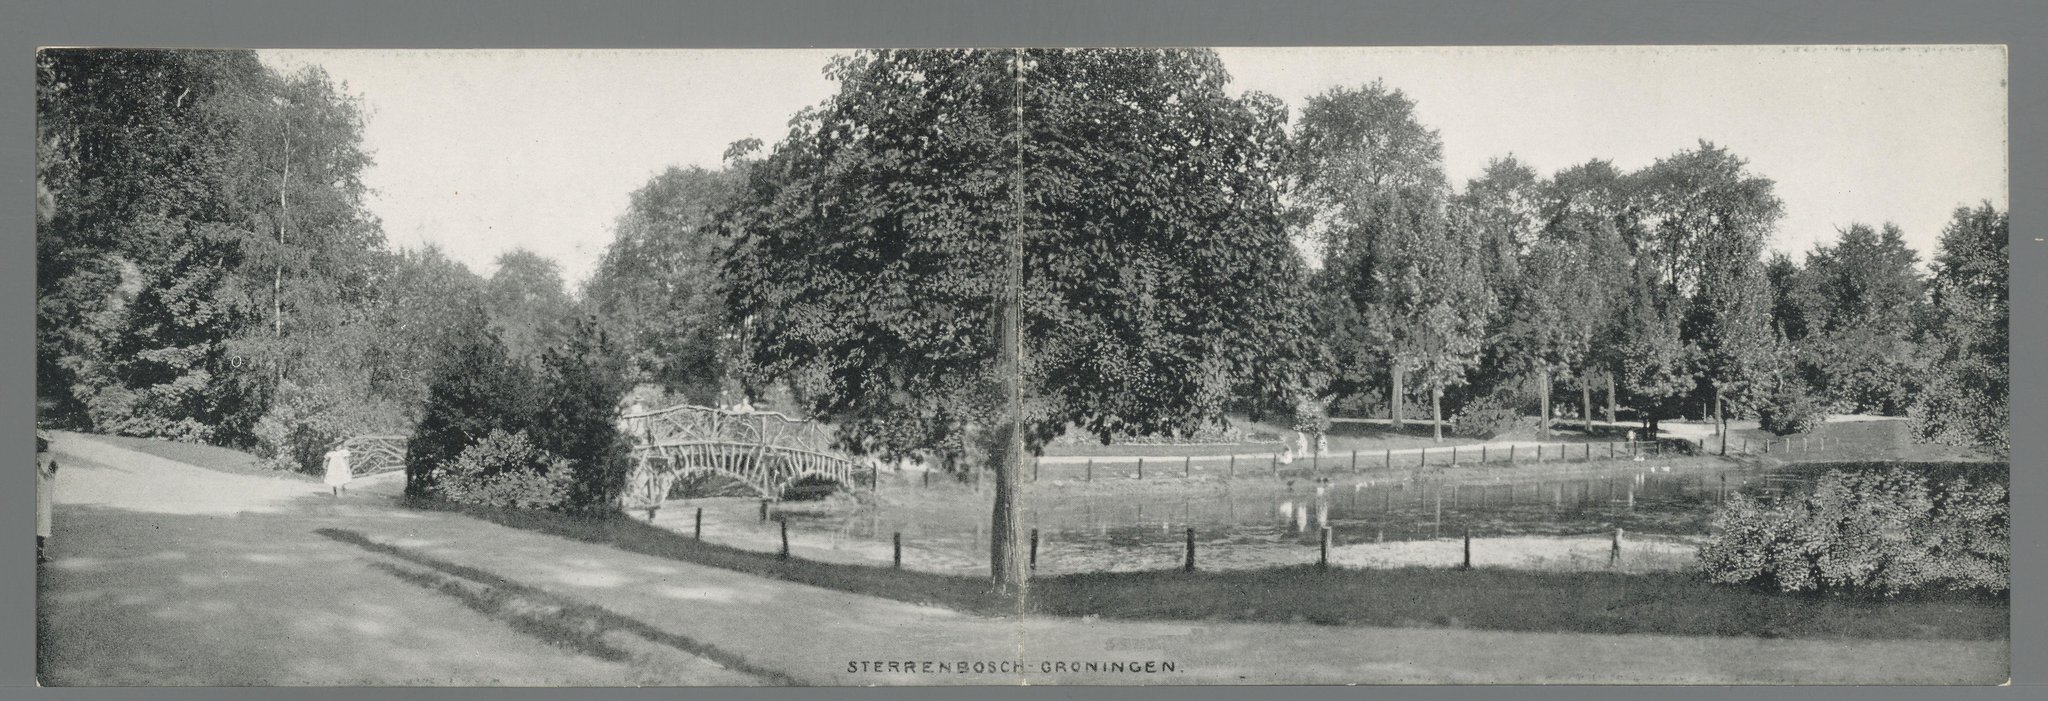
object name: photomechanical print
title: Sterrenbosch - Groningen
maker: Anonymous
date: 1892-1905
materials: cardboard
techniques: autotype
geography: groningen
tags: park, pond, bridge in city across river, canal, etc.